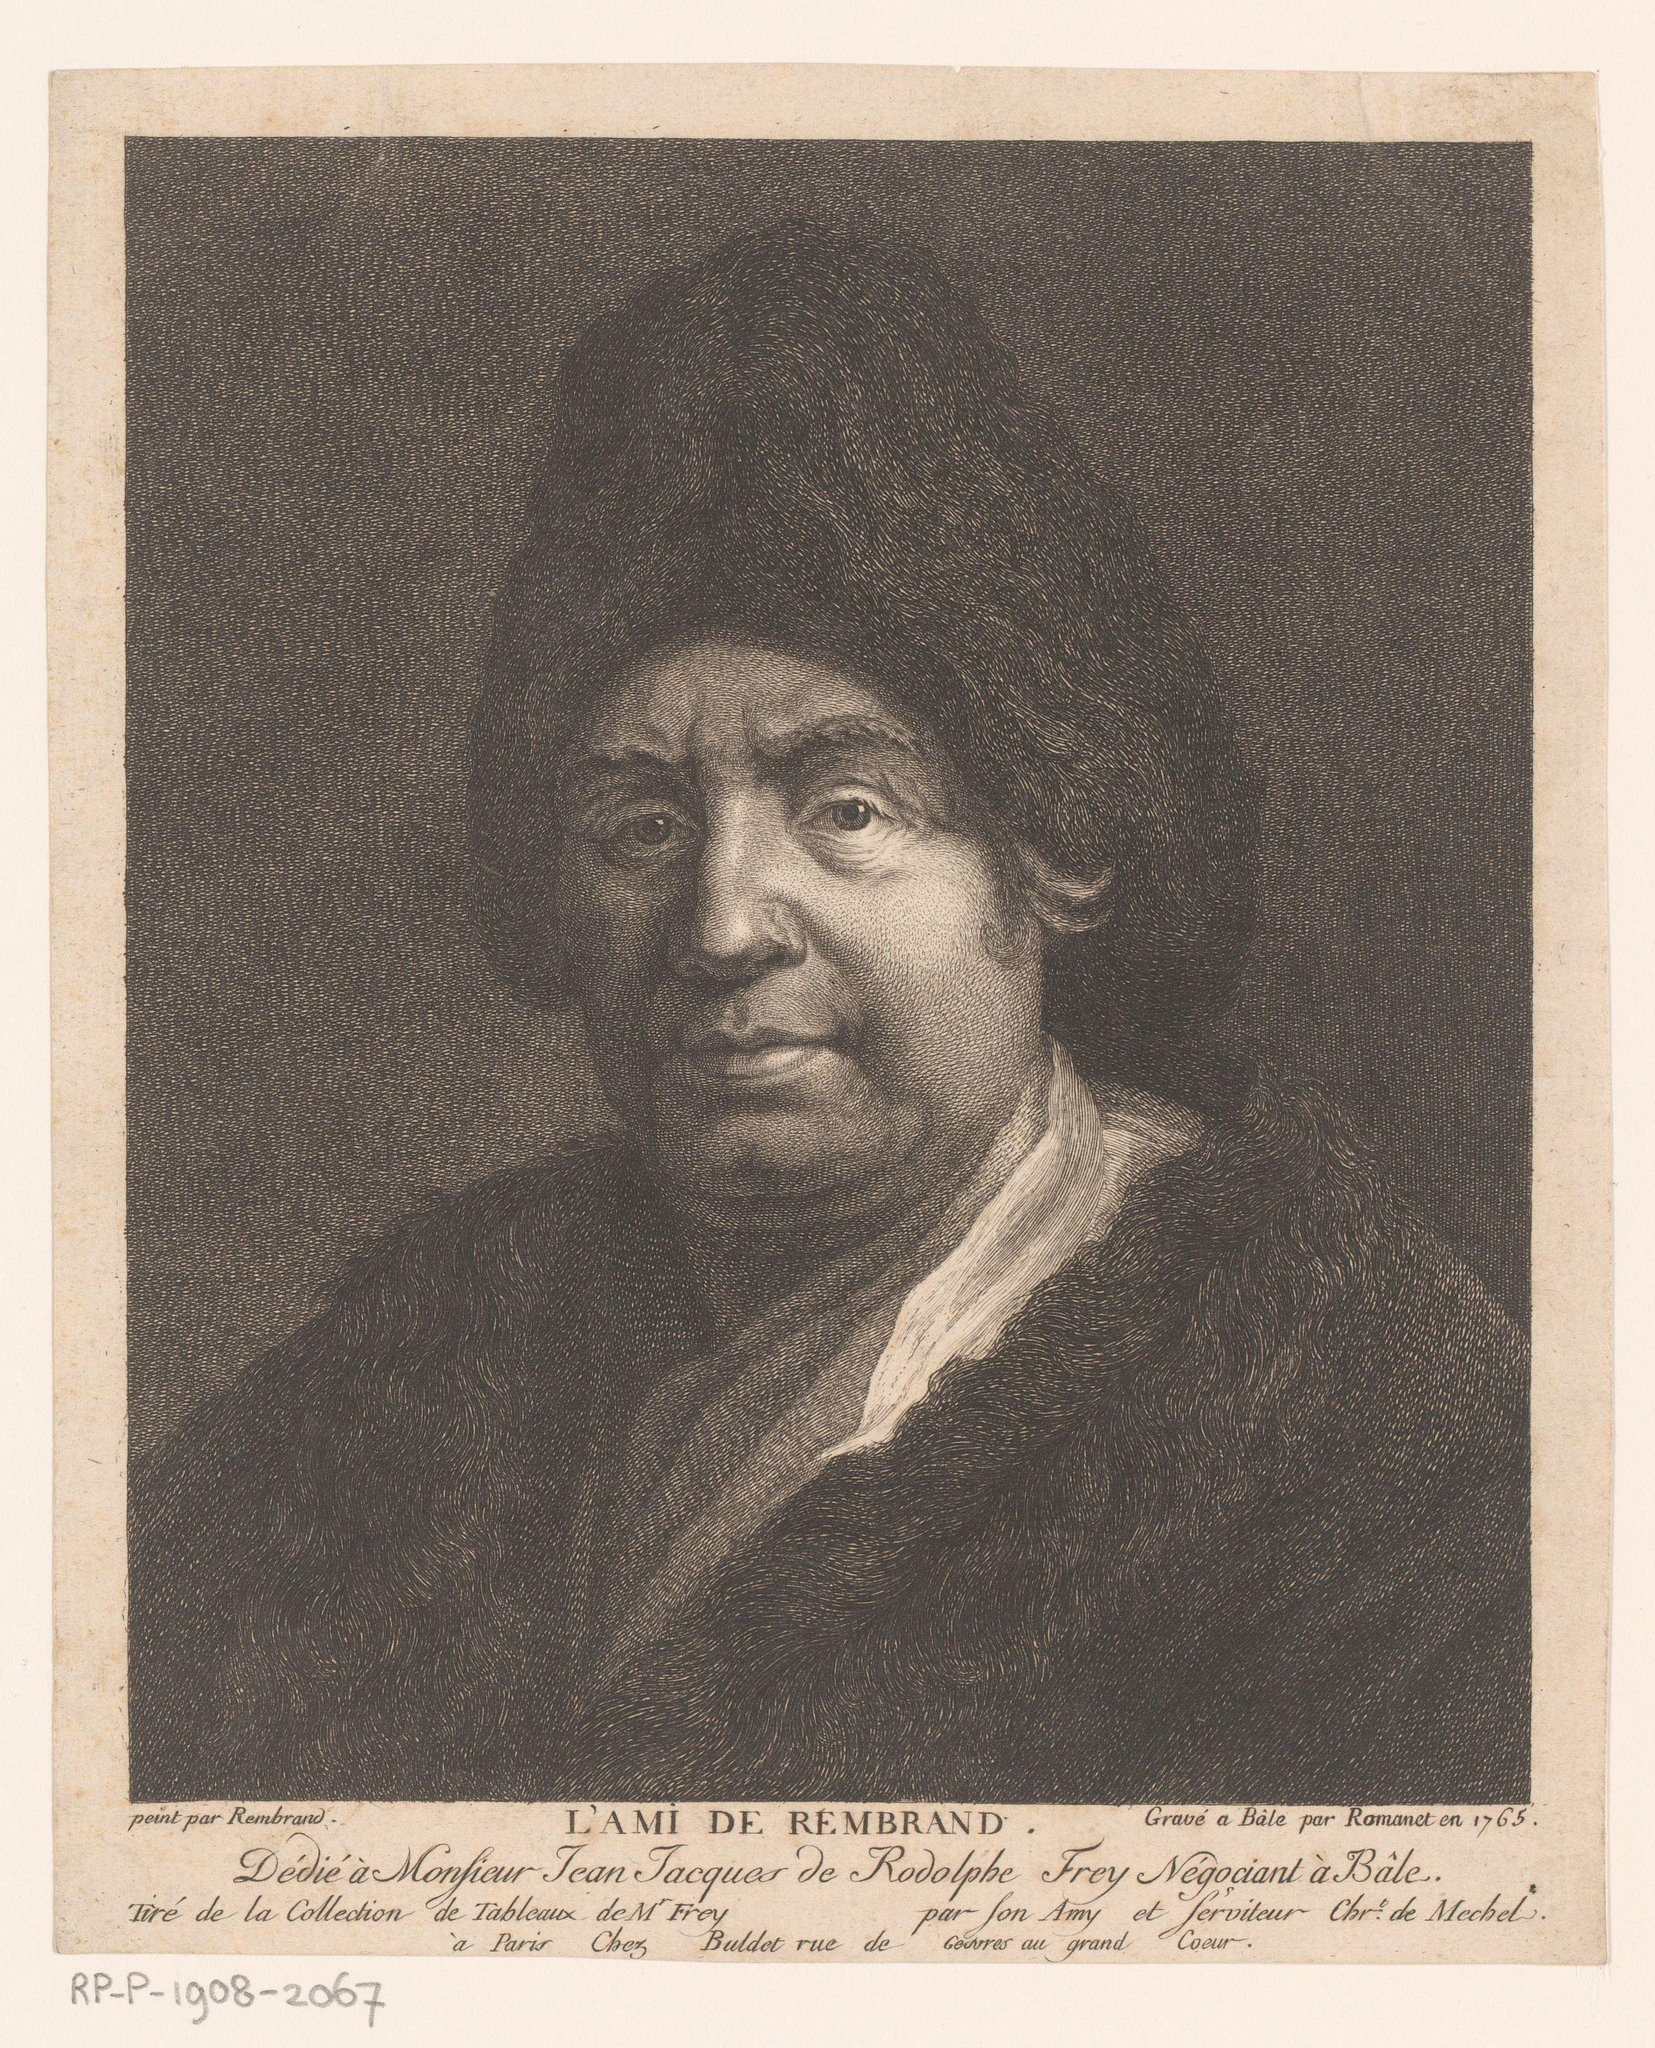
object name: print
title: Man met bontmuts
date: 1765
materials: paper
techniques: engraving, etching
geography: paris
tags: head-gear: cap (+ men's clothes)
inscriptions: collector's mark: Lugt 2228